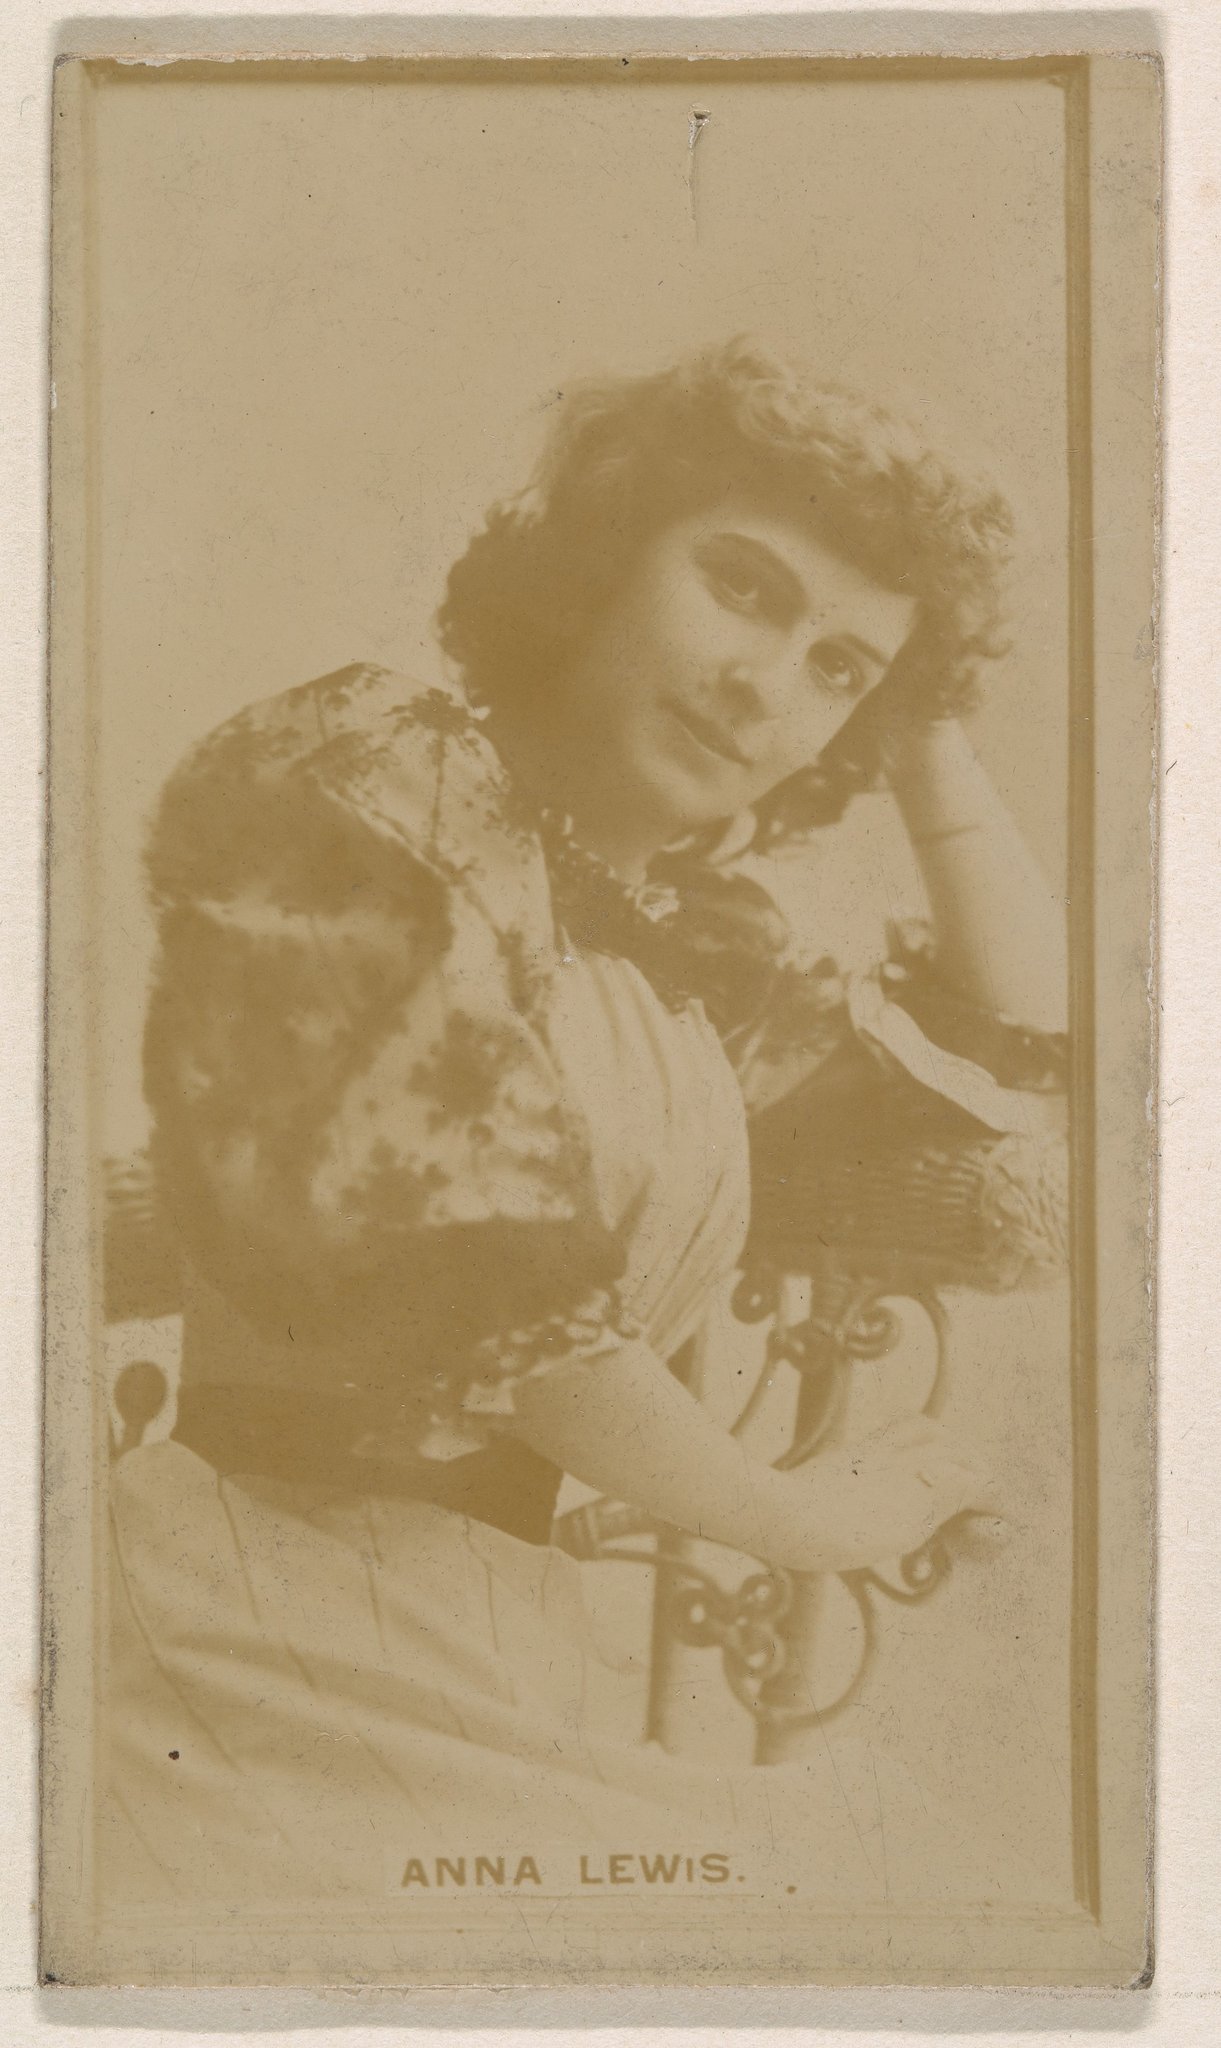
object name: photograph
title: Anna Lewis, from the Actresses series (N245) issued by Kinney Brothers to promote Sweet Caporal Cigarettes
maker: kinney brothers tobacco company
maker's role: publisher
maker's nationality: american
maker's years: 1869-2011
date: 1890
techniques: albumen silver print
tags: portraits,women,actresses